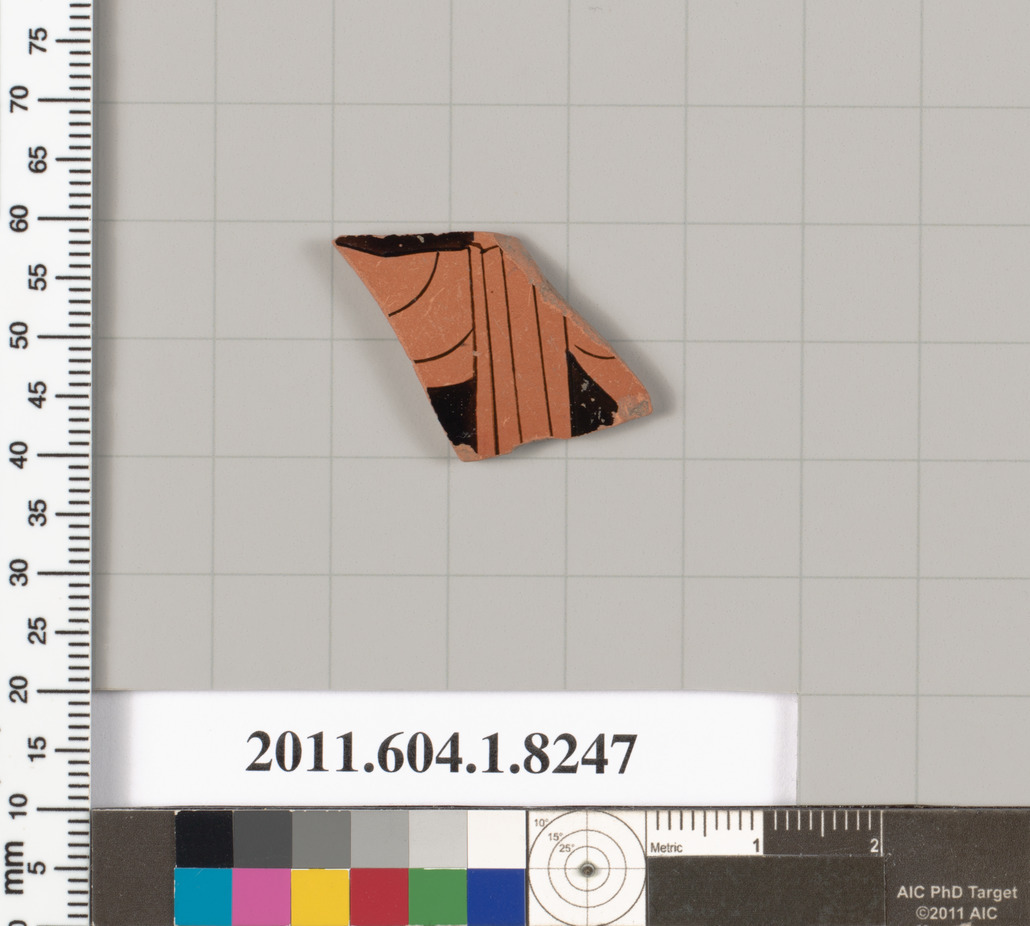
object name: kylix fragment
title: Terracotta fragment of a kylix (drinking cup)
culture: greek, attic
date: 520-510 BCE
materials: terracotta